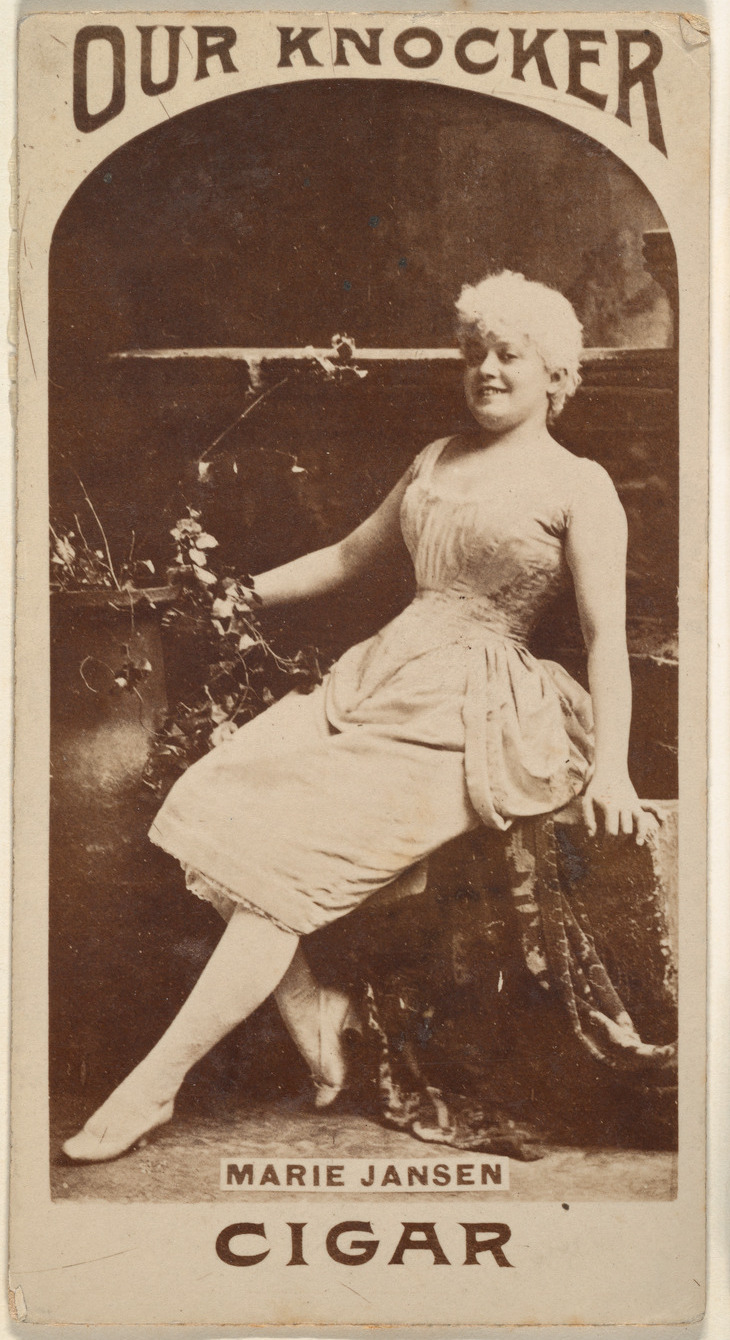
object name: photograph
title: Marie Jansen, from the Actresses series (N665) promoting Our Knocker Cigars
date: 1888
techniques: albumen silver print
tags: portraits,women,actresses